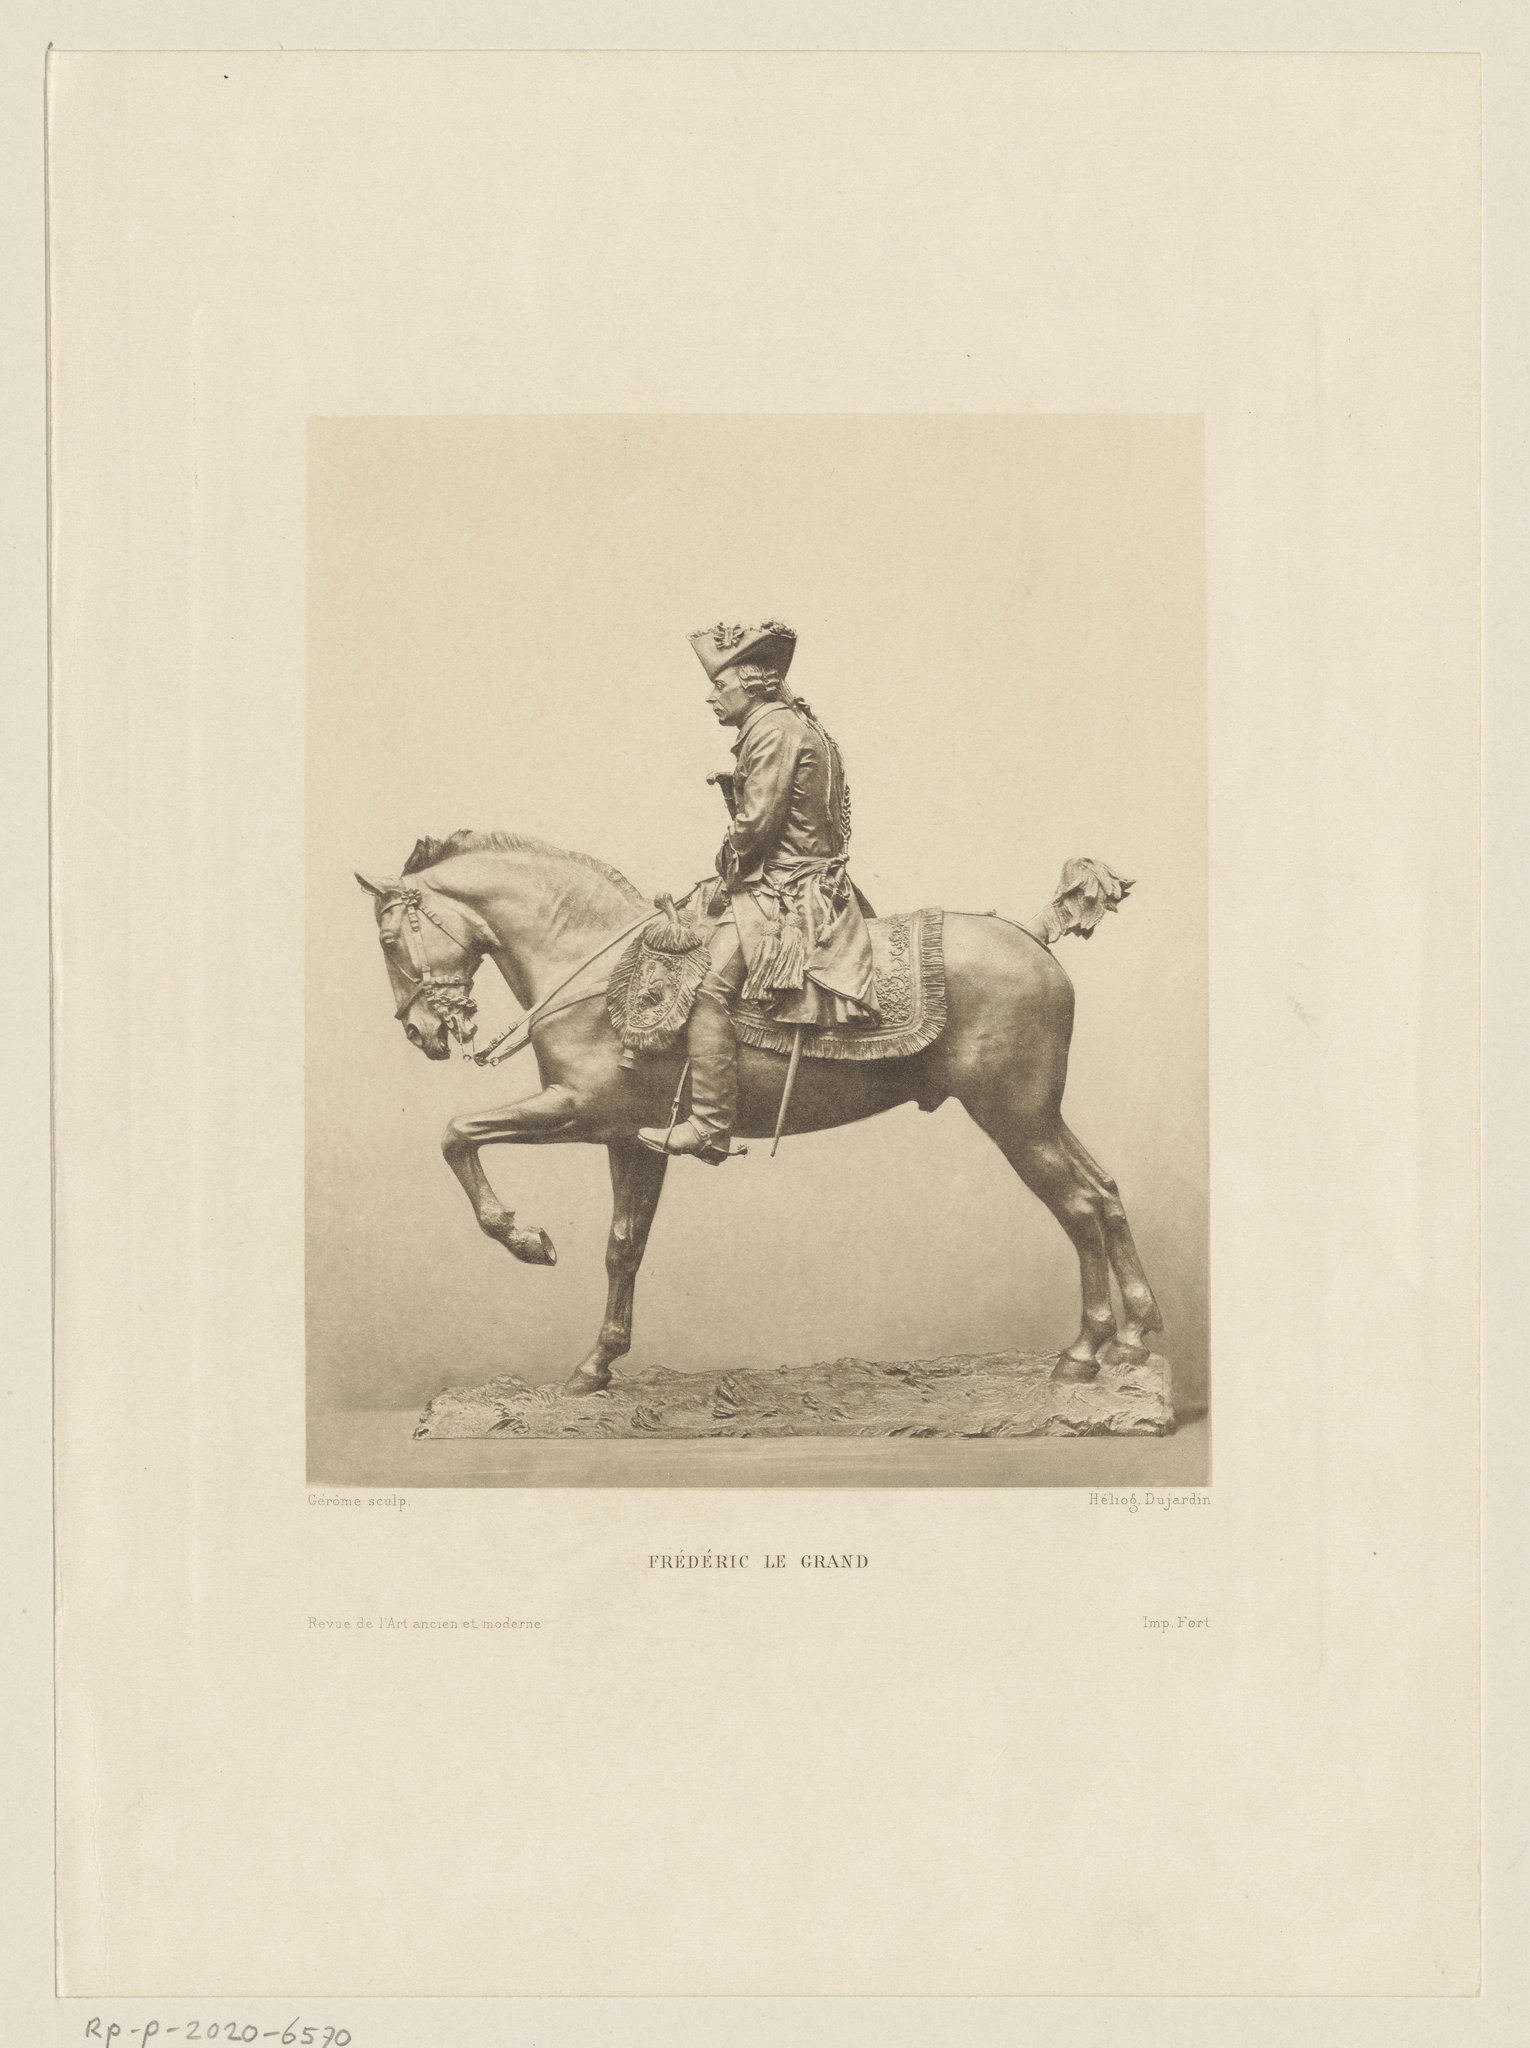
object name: photomechanical print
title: Portret van Frederik de Grote te paard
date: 1897-1915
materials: paper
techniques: photoaquatint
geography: france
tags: berlin, frederick ii (king of prussia), historical persons, equestrian statue, (military) uniforms, king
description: Prent komt uit een editie van La Revue de l'art ancien et moderne.